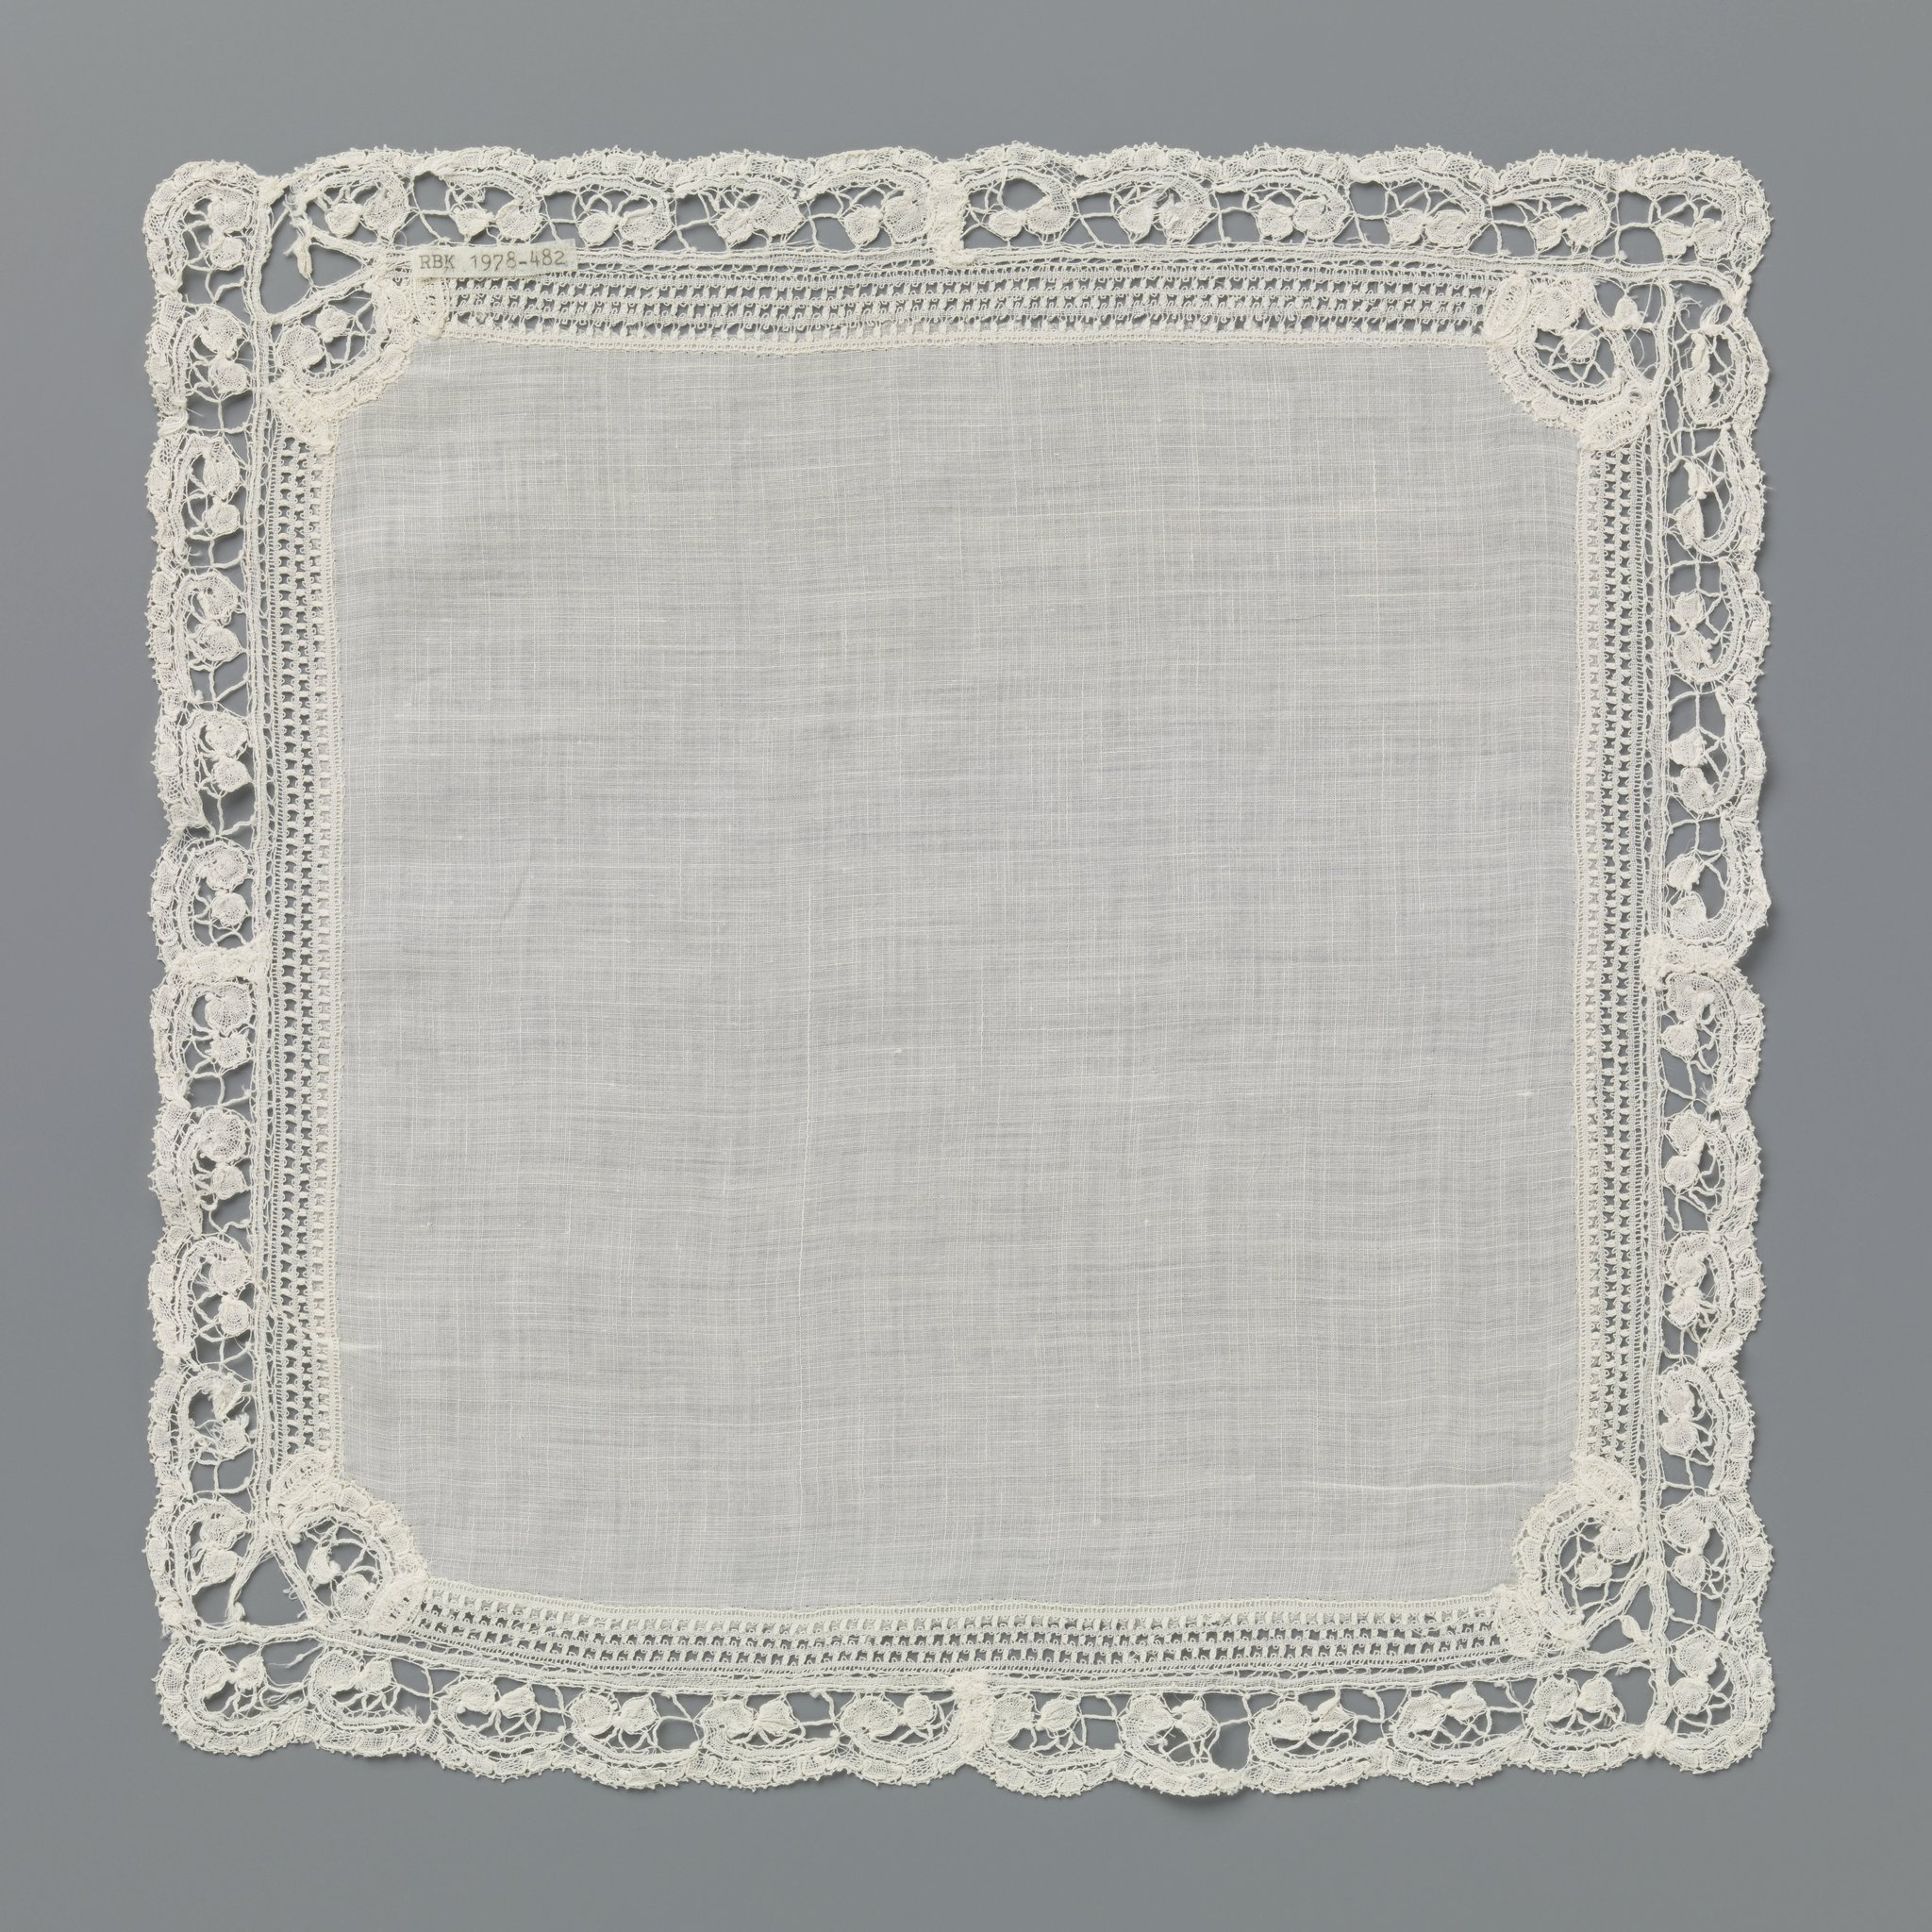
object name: handkerchief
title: Zakdoek van batist met dubbele sierlijst met leerkens en j-vormige motiefjes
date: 1890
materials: textile, cotton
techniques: lace, weave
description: Zakdoek van naturelkleurige batist rondom afgewerkt met naturelkleurige kloskant: fijn Brugs bloemwerk. Het kloskant bestaat langs de randen van de zakdoek uit een dubbele sierlijst. De binnenste sierlijst bestaat uit vier uiterst smalle lijnen die met elkaar verbonden zijn door vierkante vormslagen. De siervulling waaruit deze lijst bestaat wordt ook wel 'leerkens' (laddertjes) genoemd. Hieraan vast zit de tweede, buitenste, sierlijst met een zich herhalend patroon van één rij j-vormige krullen met een stip boven het omkrullende uiteinde. De j-vormige motieven zijn met een vlechtengrond verbonden aan elkaar en aan de binnenste sierlijst. Buitenlangs zijn ze verbonden aan de flauwe schulpenrand, die wordt gevormd door een aaneenschakeling van vlakjes, afwisselend gemaakt in linnenslag en netslag, waar een dikke contourdraad omheen slingerd. In elke hoek staat overhoeks geplaatst een j-vormig motiefje met dito vlakjes, maar dan zijn de vlakjes naar binnen gericht en raken het batist. De motieven zijn gemaakt in linnenslag en deels in netslag (de vlakjes) met opengewerkte randjes en dikke contourlijnen. De schulpenrand is afgewerkt met picots.